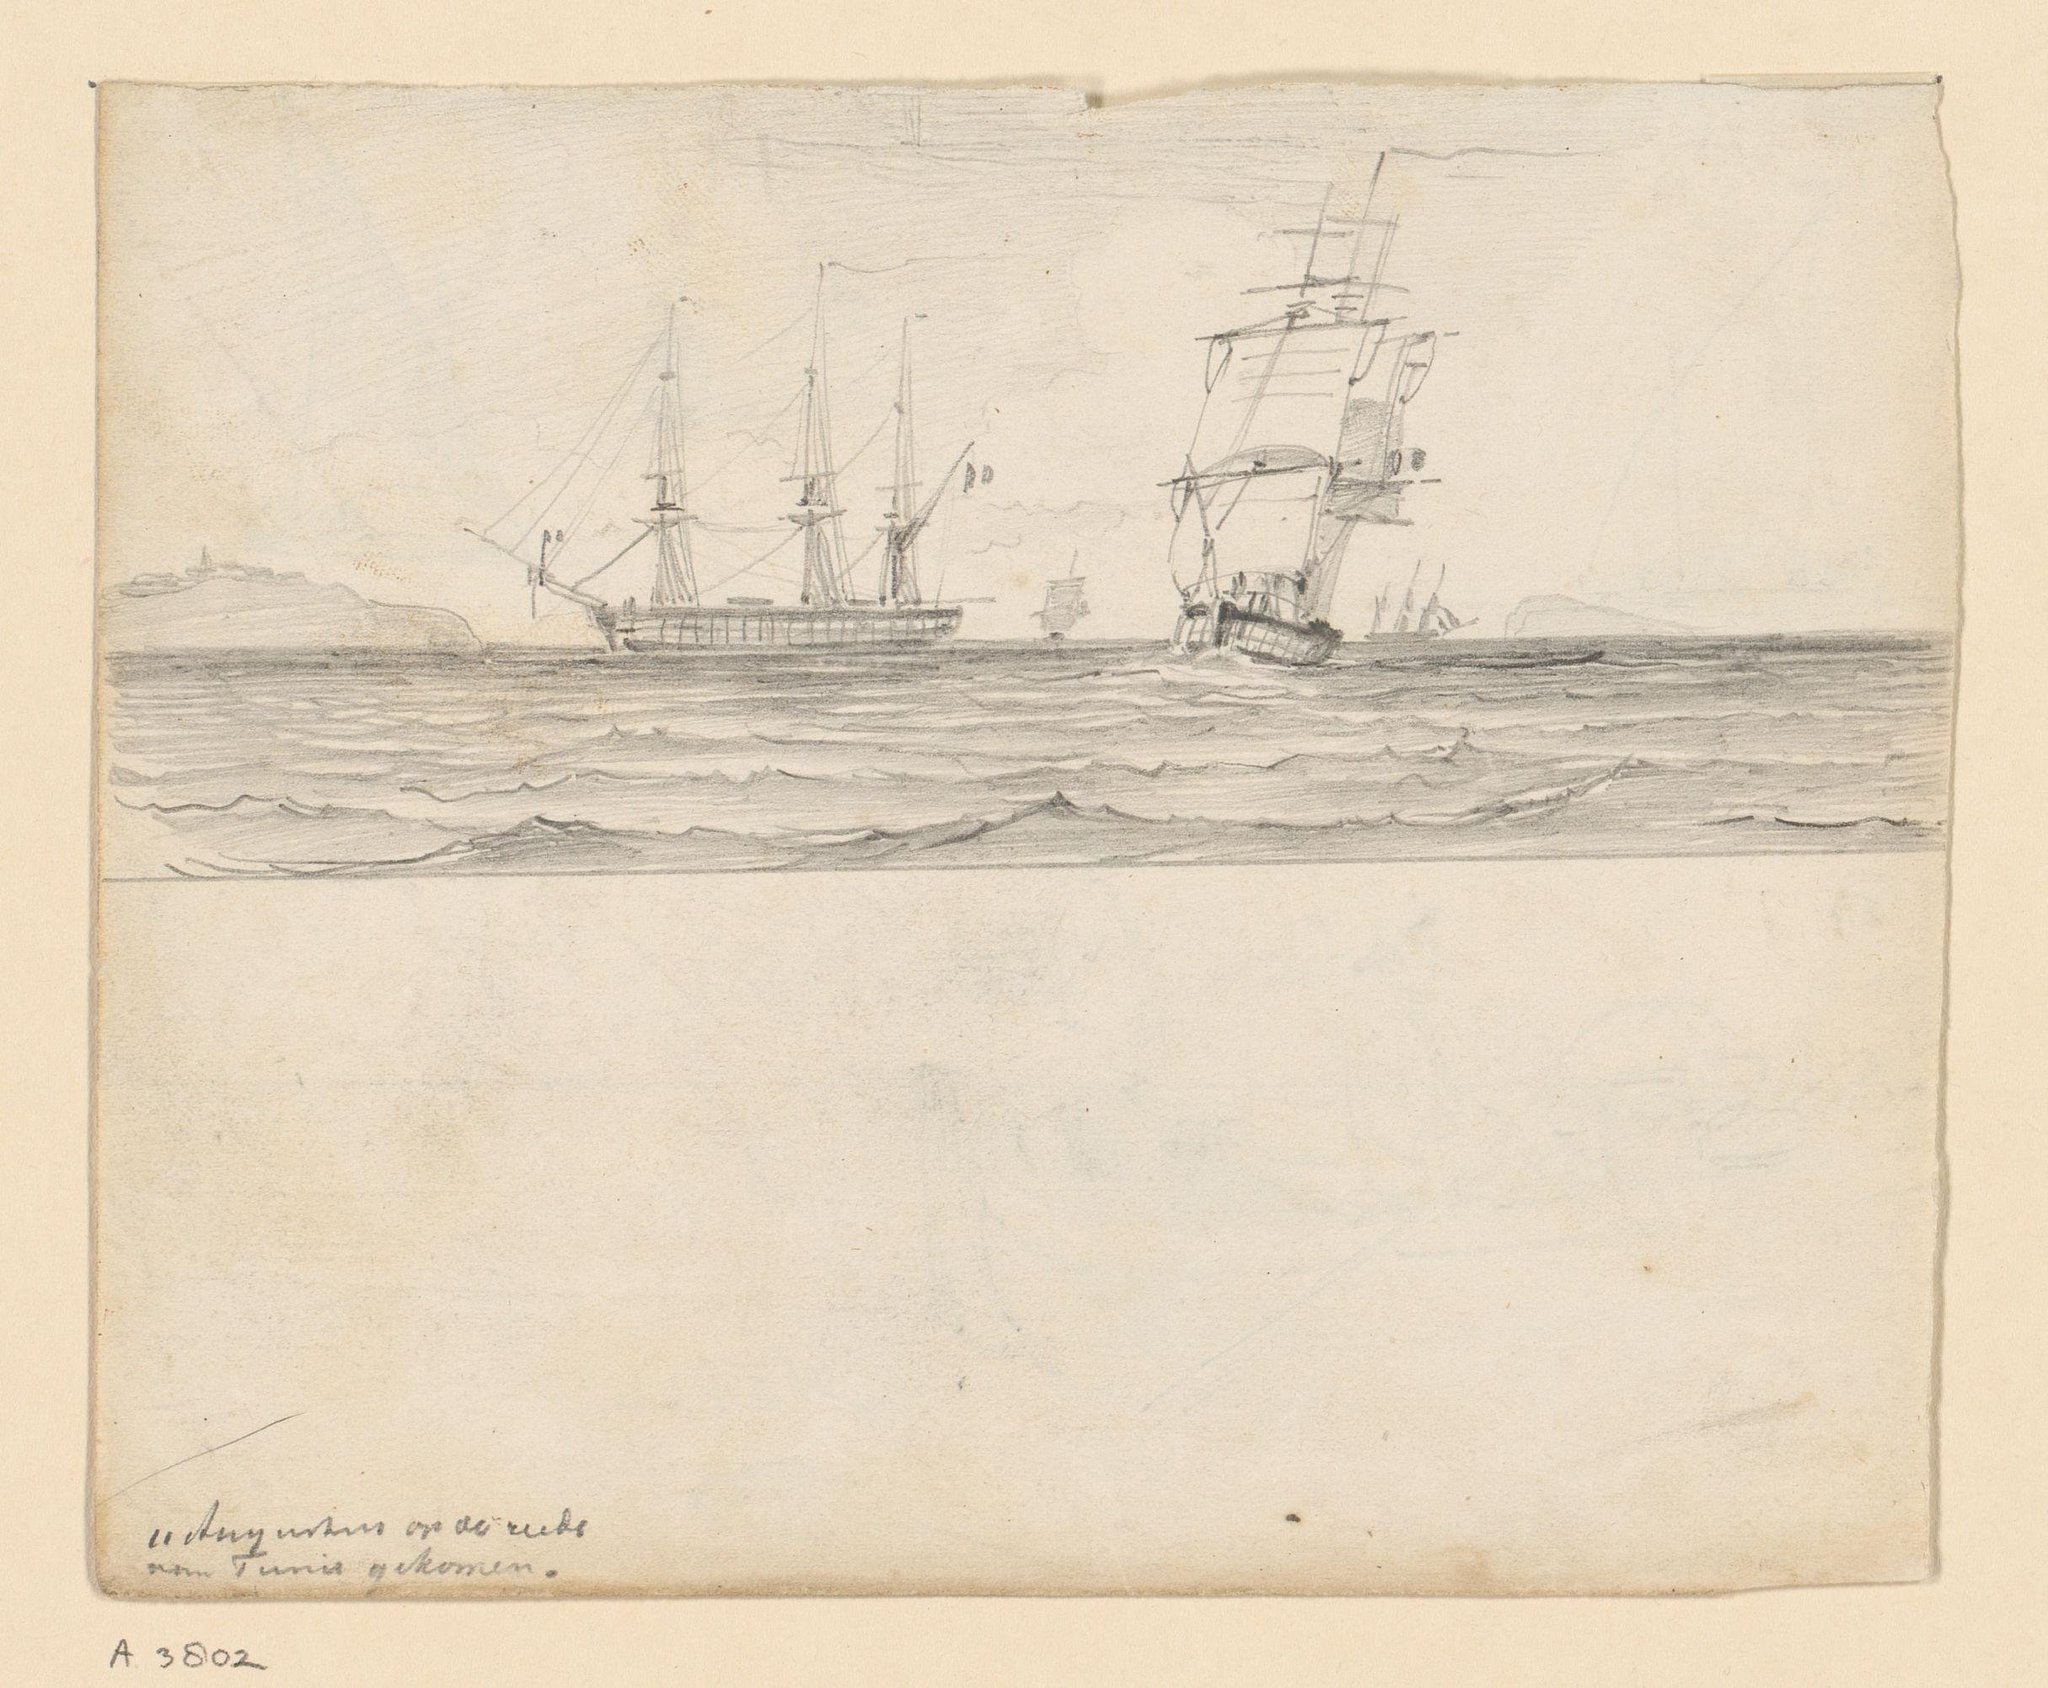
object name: drawing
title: De rede van Tunis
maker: willem anthonie van deventer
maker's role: draughtsman, painter, print maker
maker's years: 1824-1893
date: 1834-1893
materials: paper, pencil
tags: ship in the roads, roadstead